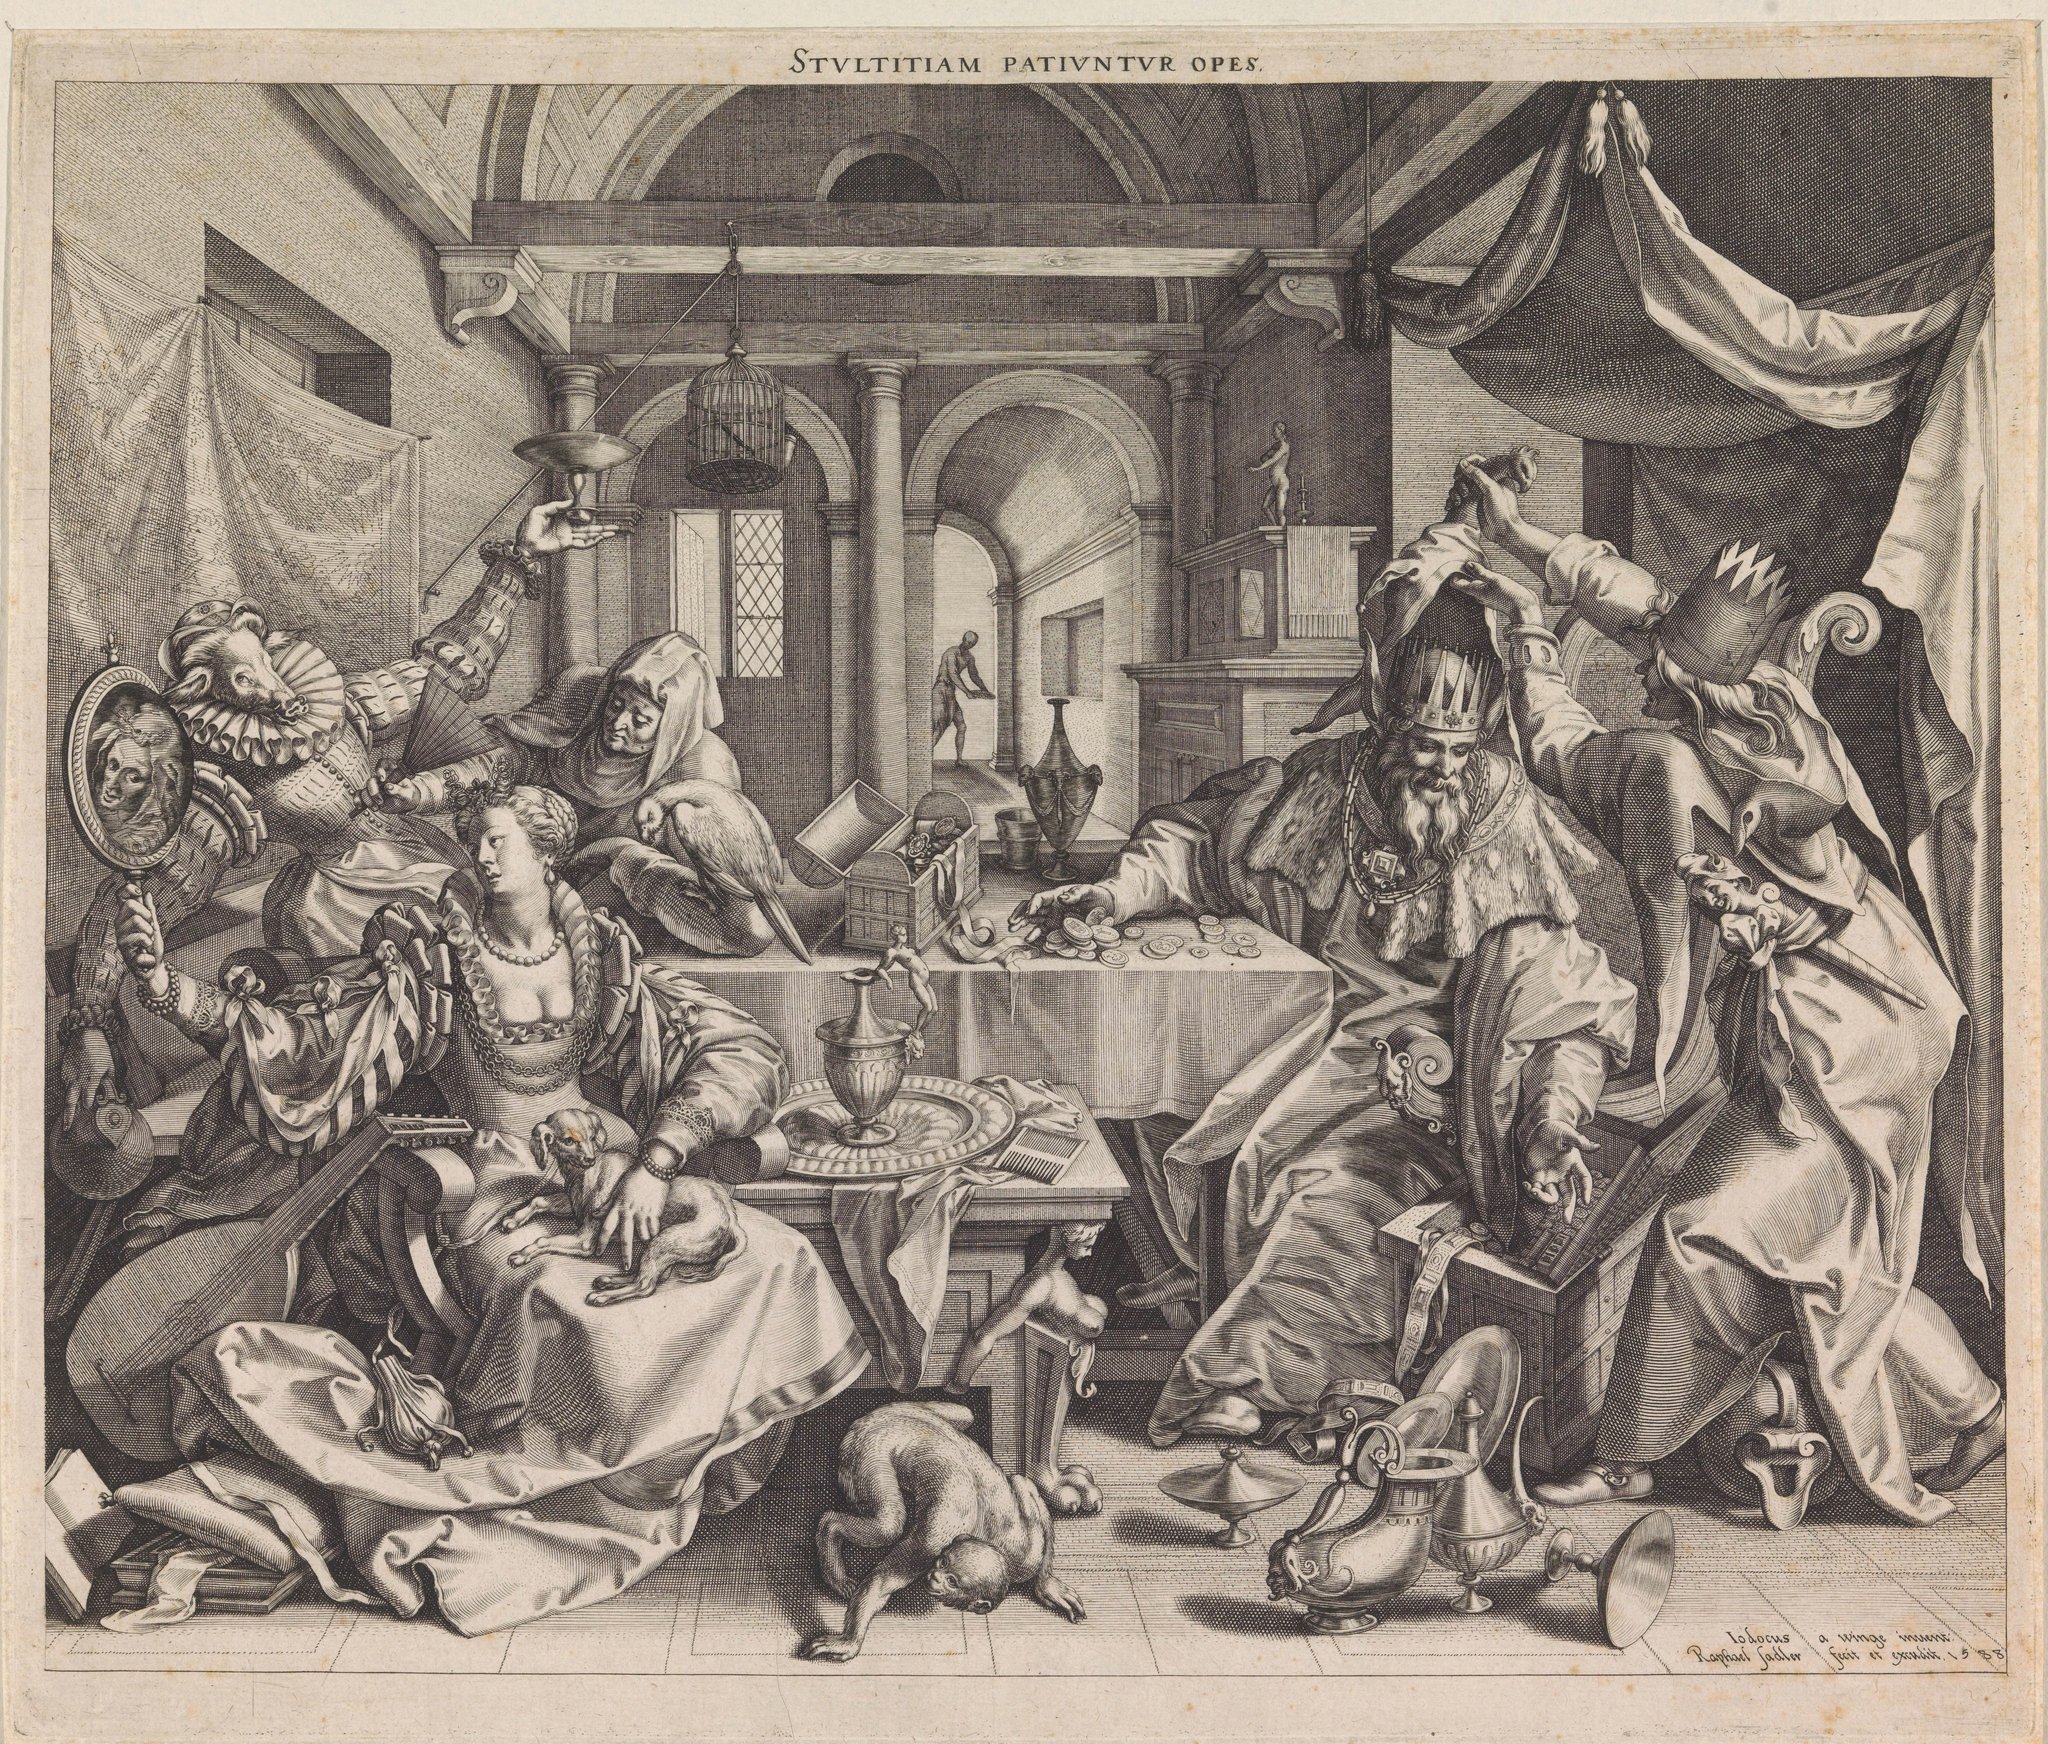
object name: print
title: Allegorie op rijkdom, wellust en domheid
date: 1588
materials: paper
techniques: engraving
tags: monsters with animal head - aa - female human figure, flattery; 'adulatione' (ripa), court jester, court fool, monkeys, apes, ornamental birds: parrot, wealth, opulence; 'opulenza', 'richezza' (ripa), folly, foolishness; 'pazzia', 'sciocchezza', 'stoltitia' (ripa), fool's cap, (story of) midas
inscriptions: collector's mark: Lugt 240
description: Een interieur van een huis. Aan een tafel zitten koning Midas, als personificatie van dwaasheid en hebzucht, en de vrouwelijk personificatie van Rijkdom. Midas is zijn geld aan het tellen, terwijl een nar, de personificatie van Dwaasheid, hem een zotskap opzet. Rijkdom bekijkt haar reflectie in een spiegel en ziet een oude vrouw. Een dame met het hoofd van een zwijn schenkt haar wijn in. Een andere vrouw met een papegaai op haar arm zwaait haar met een waaier haar koelte toe (zij personifieert artificiële lof of vleierij).